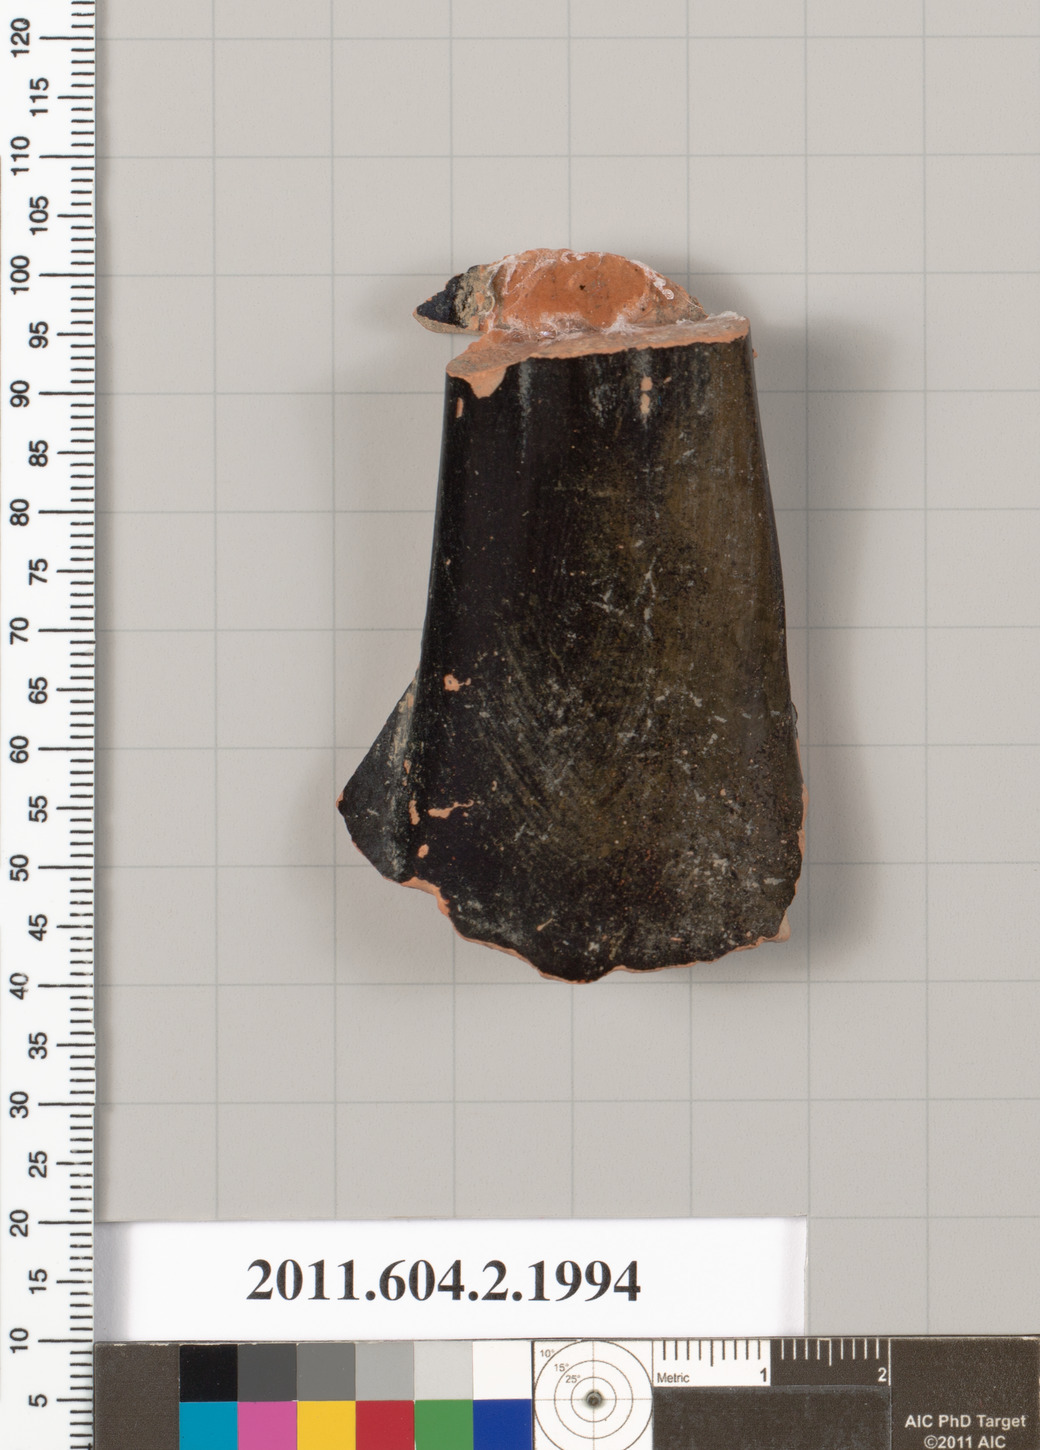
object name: pelike fragment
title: Terracotta fragment of a pelike (jar)?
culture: greek, attic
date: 475-451 BCE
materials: terracotta